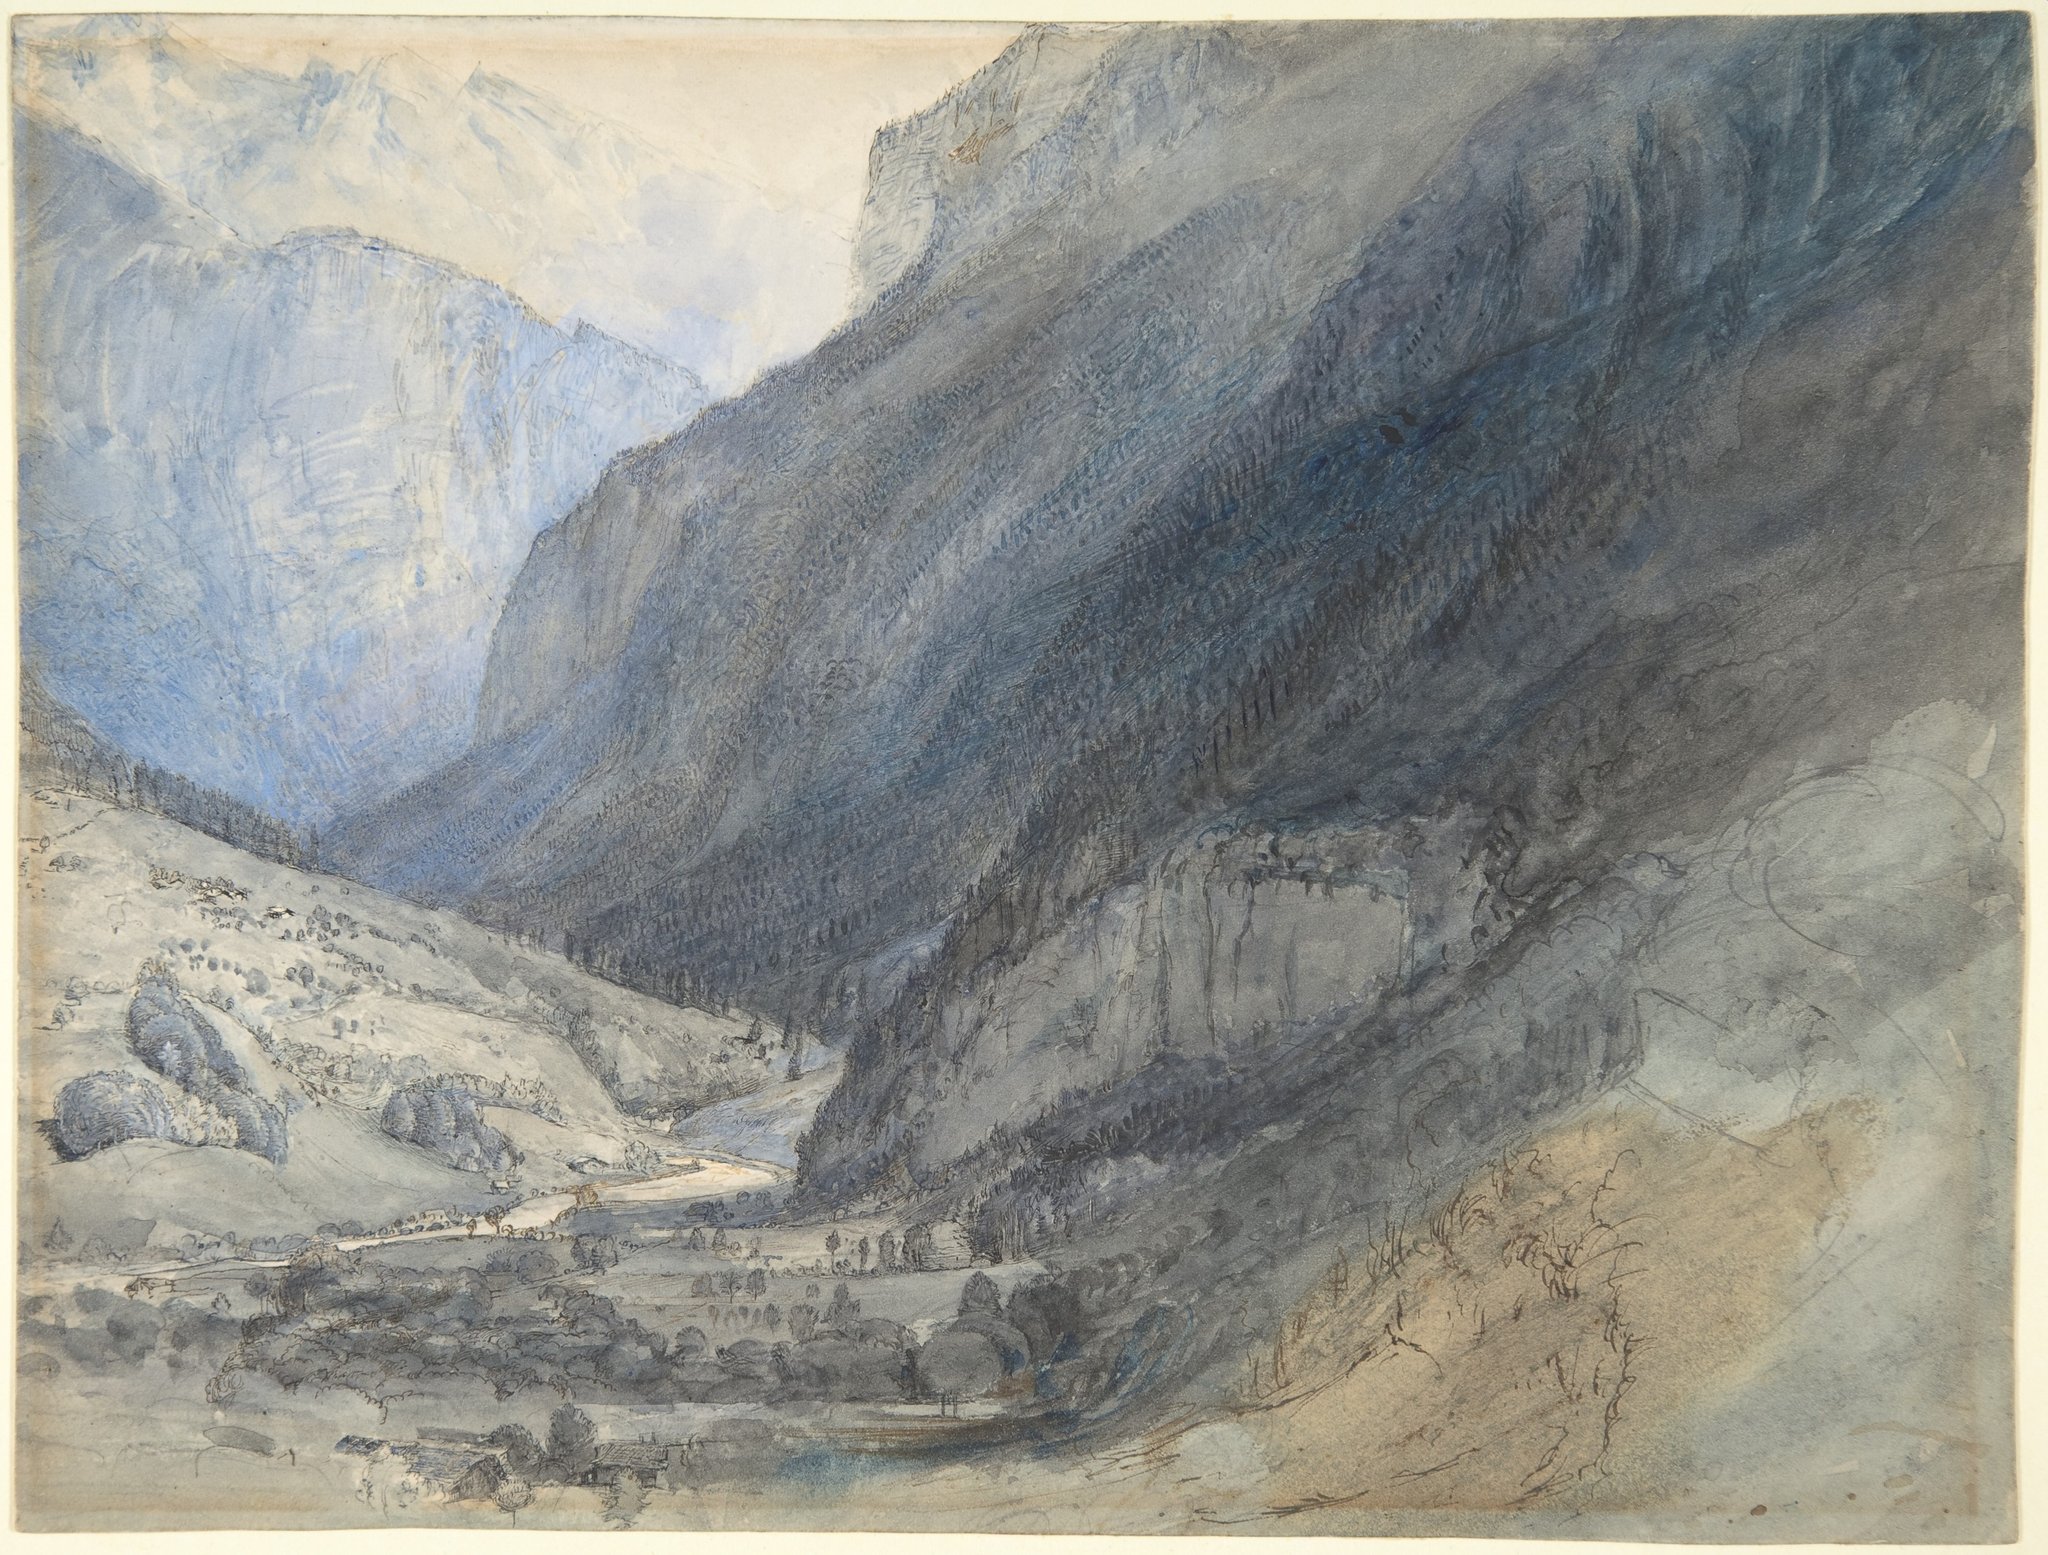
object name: drawing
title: The Valley of Lauterbrunnen, Switzerland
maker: john ruskin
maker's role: artist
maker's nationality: british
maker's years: 1819-1900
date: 1866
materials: gouache, graphite, ink, watercolor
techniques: pen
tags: mountains